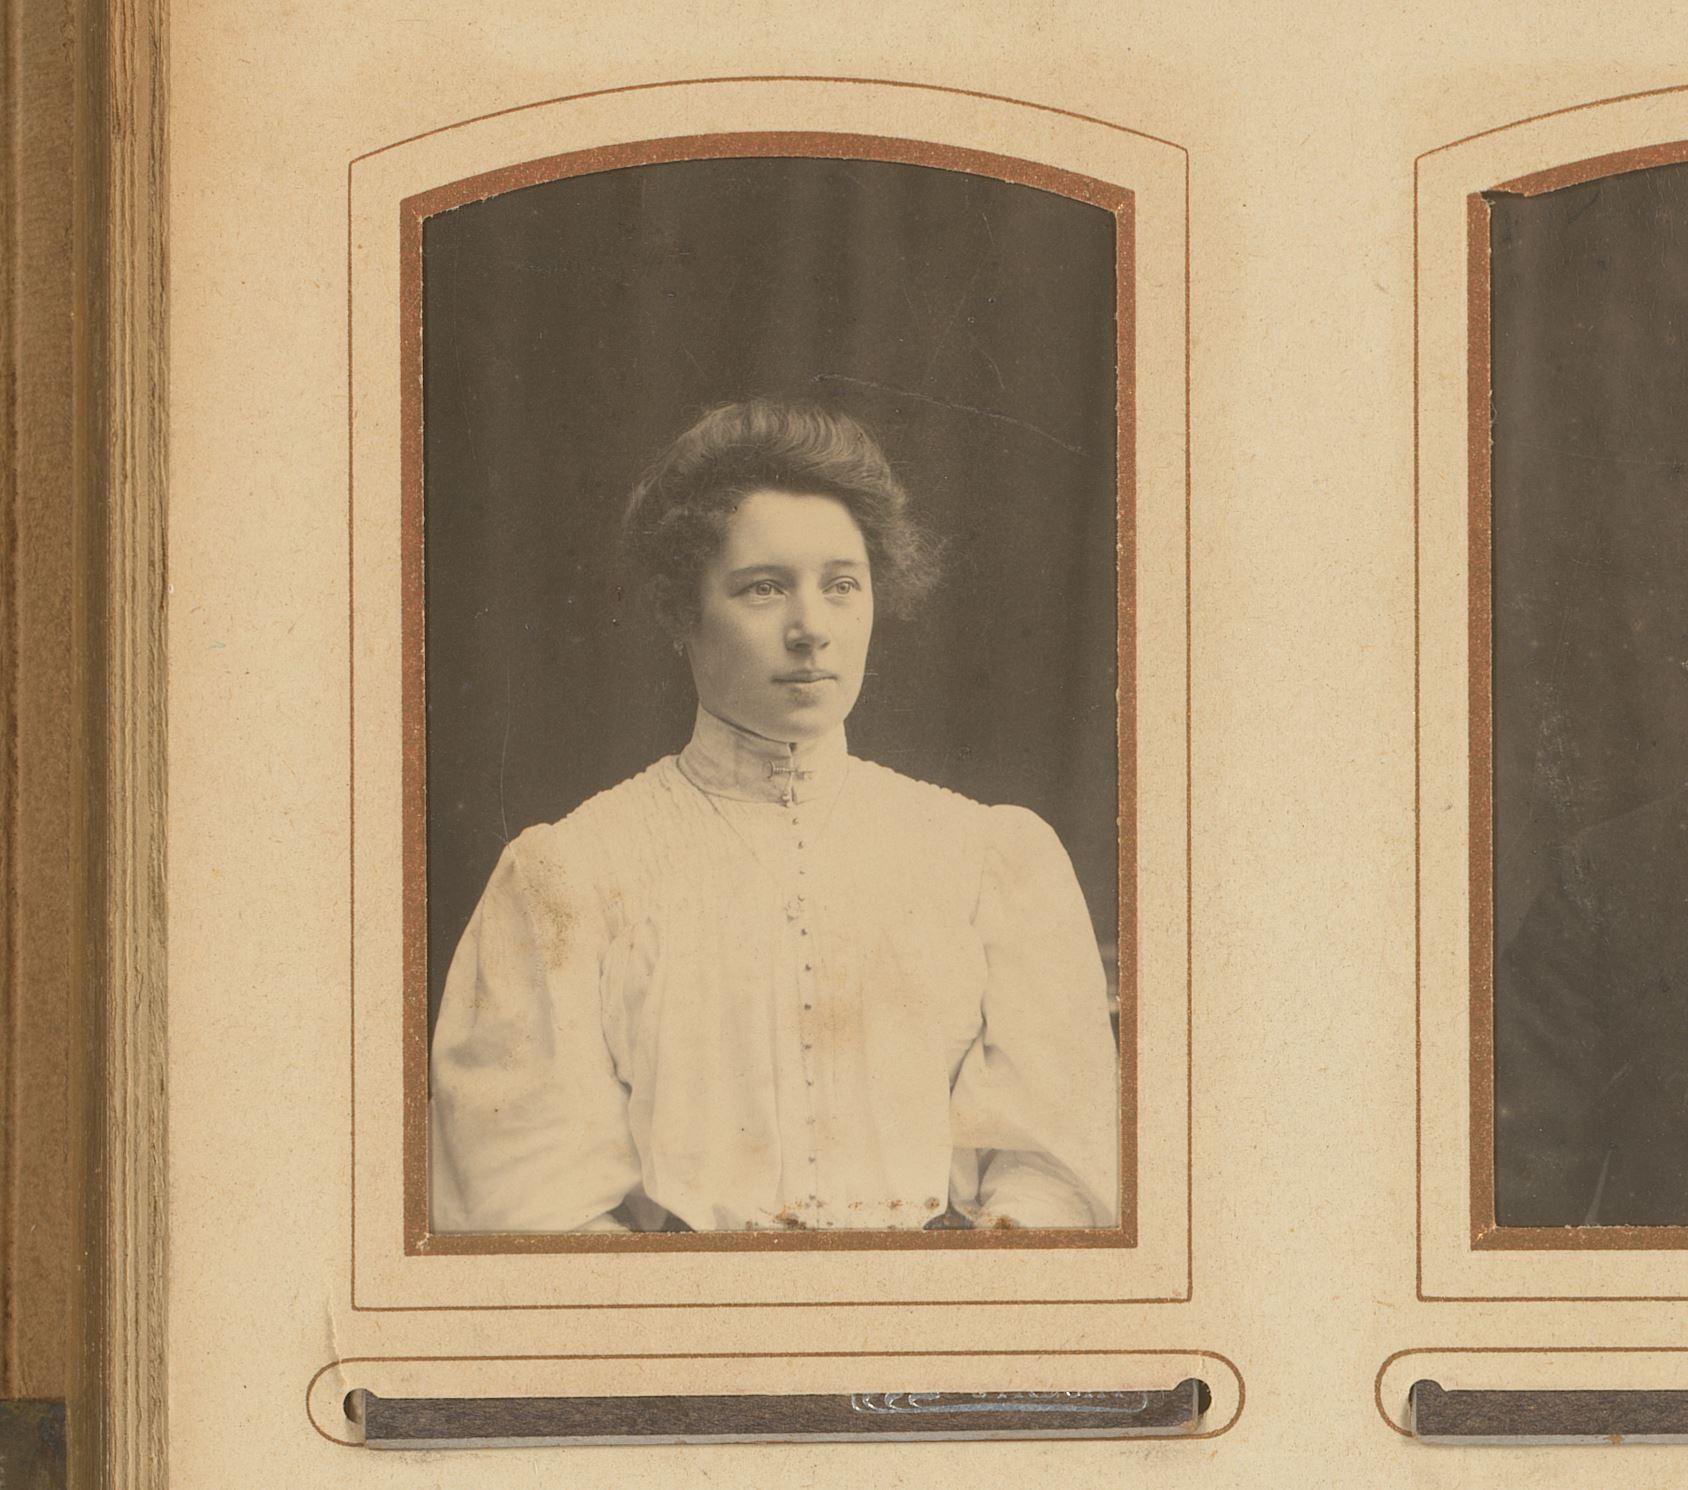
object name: photograph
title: Portret van een jonge vrouw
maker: anton cornelis thomann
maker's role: fotograaf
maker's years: 1873-1946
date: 1894-1920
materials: cardboard, photographic support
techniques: collodion silver print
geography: utrecht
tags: adolescent, young woman, maiden, historical persons - bb - woman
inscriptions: inscription: ‘Anton C. Thomann/ Photograaf/ Utrecht’